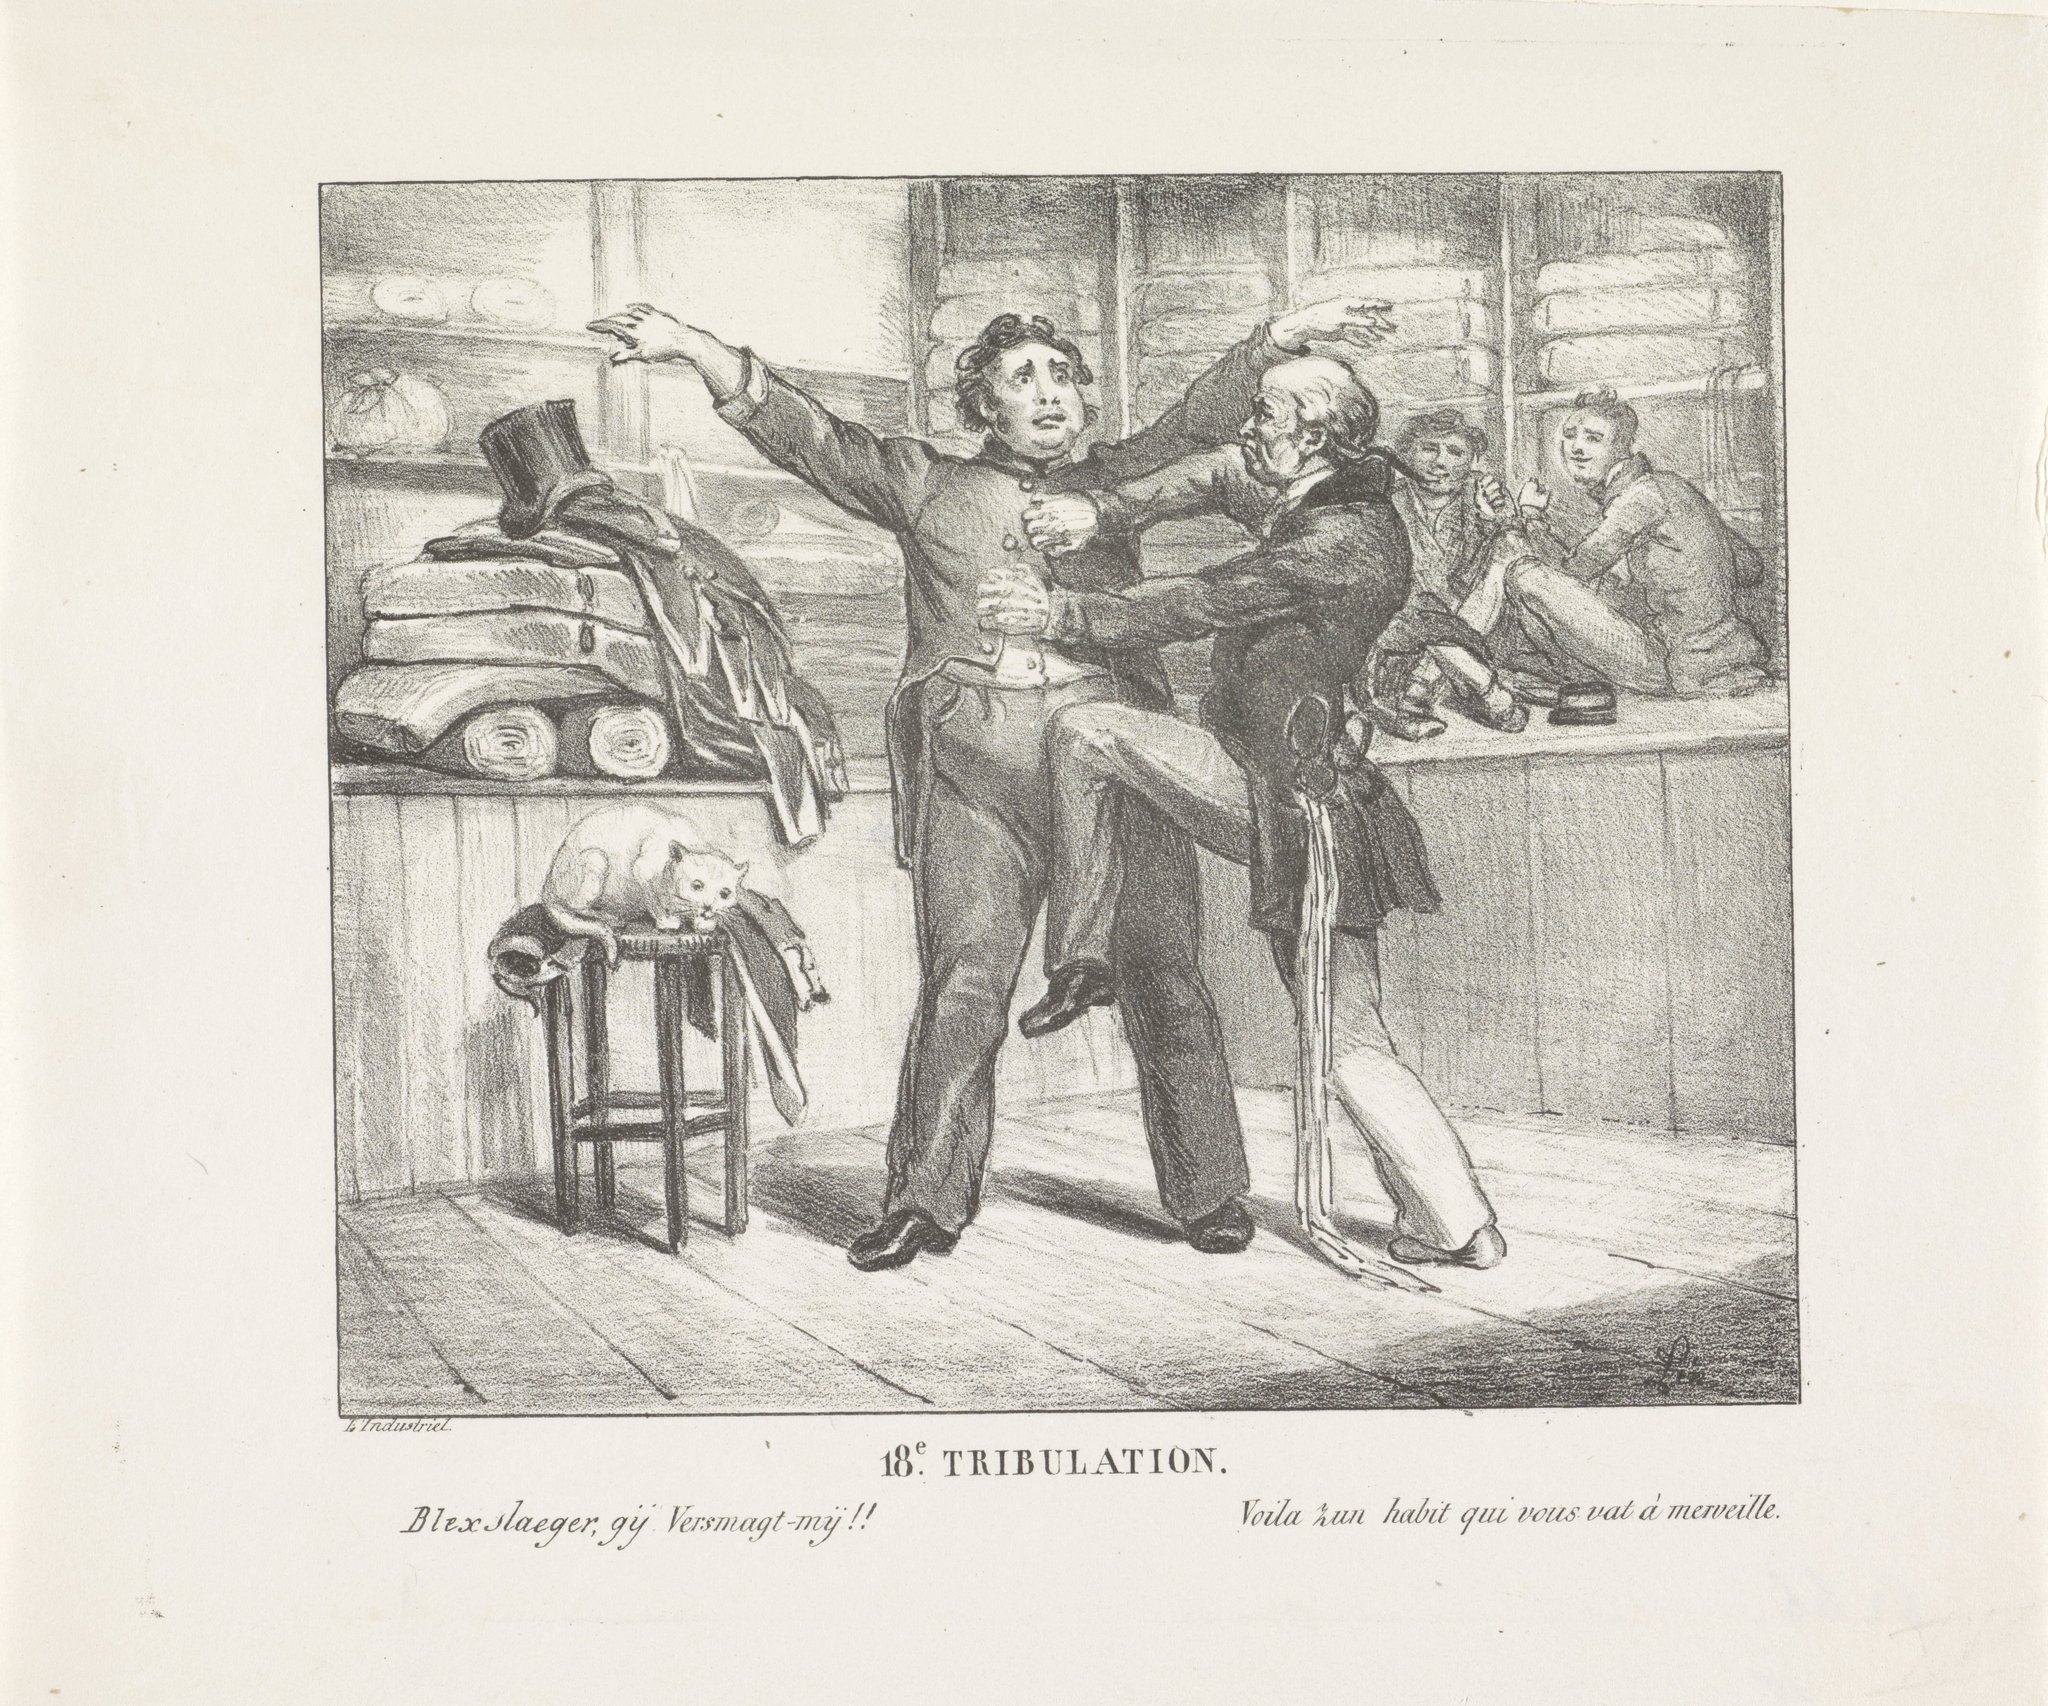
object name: print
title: Achttiende beproeving, 1828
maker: Anonymous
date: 1828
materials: paper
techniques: lithograph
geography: southern netherlands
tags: the soldier; the soldier's life, tailor, dressmaker, belgium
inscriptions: collector's mark: Lugt 2228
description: Een dikke man krijgt bij de kleermaker een te kleine uniformjas. Onderdeel van een serie van ca. 24 spotprenten uit 1828 op de wanverhoudingen binnen de Belgische schutterijen door de maatschappelijke ongelijkheid binnen het korps, na de reorganisatie ingevoerd op 11 april 1827.